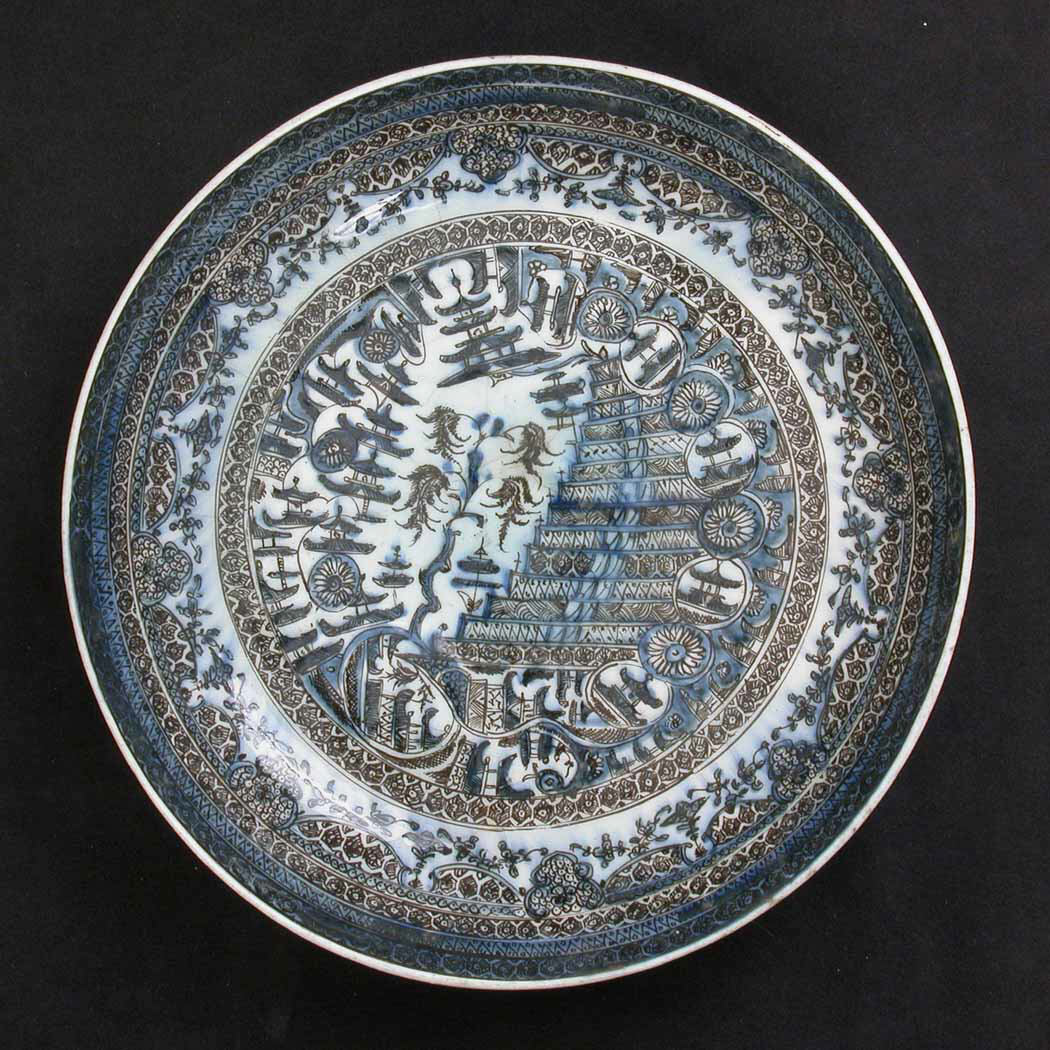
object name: bowl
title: Bowl with Pagodas and Landscape Elements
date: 1701-1800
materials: glaze, stonepaste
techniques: painting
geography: iran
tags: towers,flowers